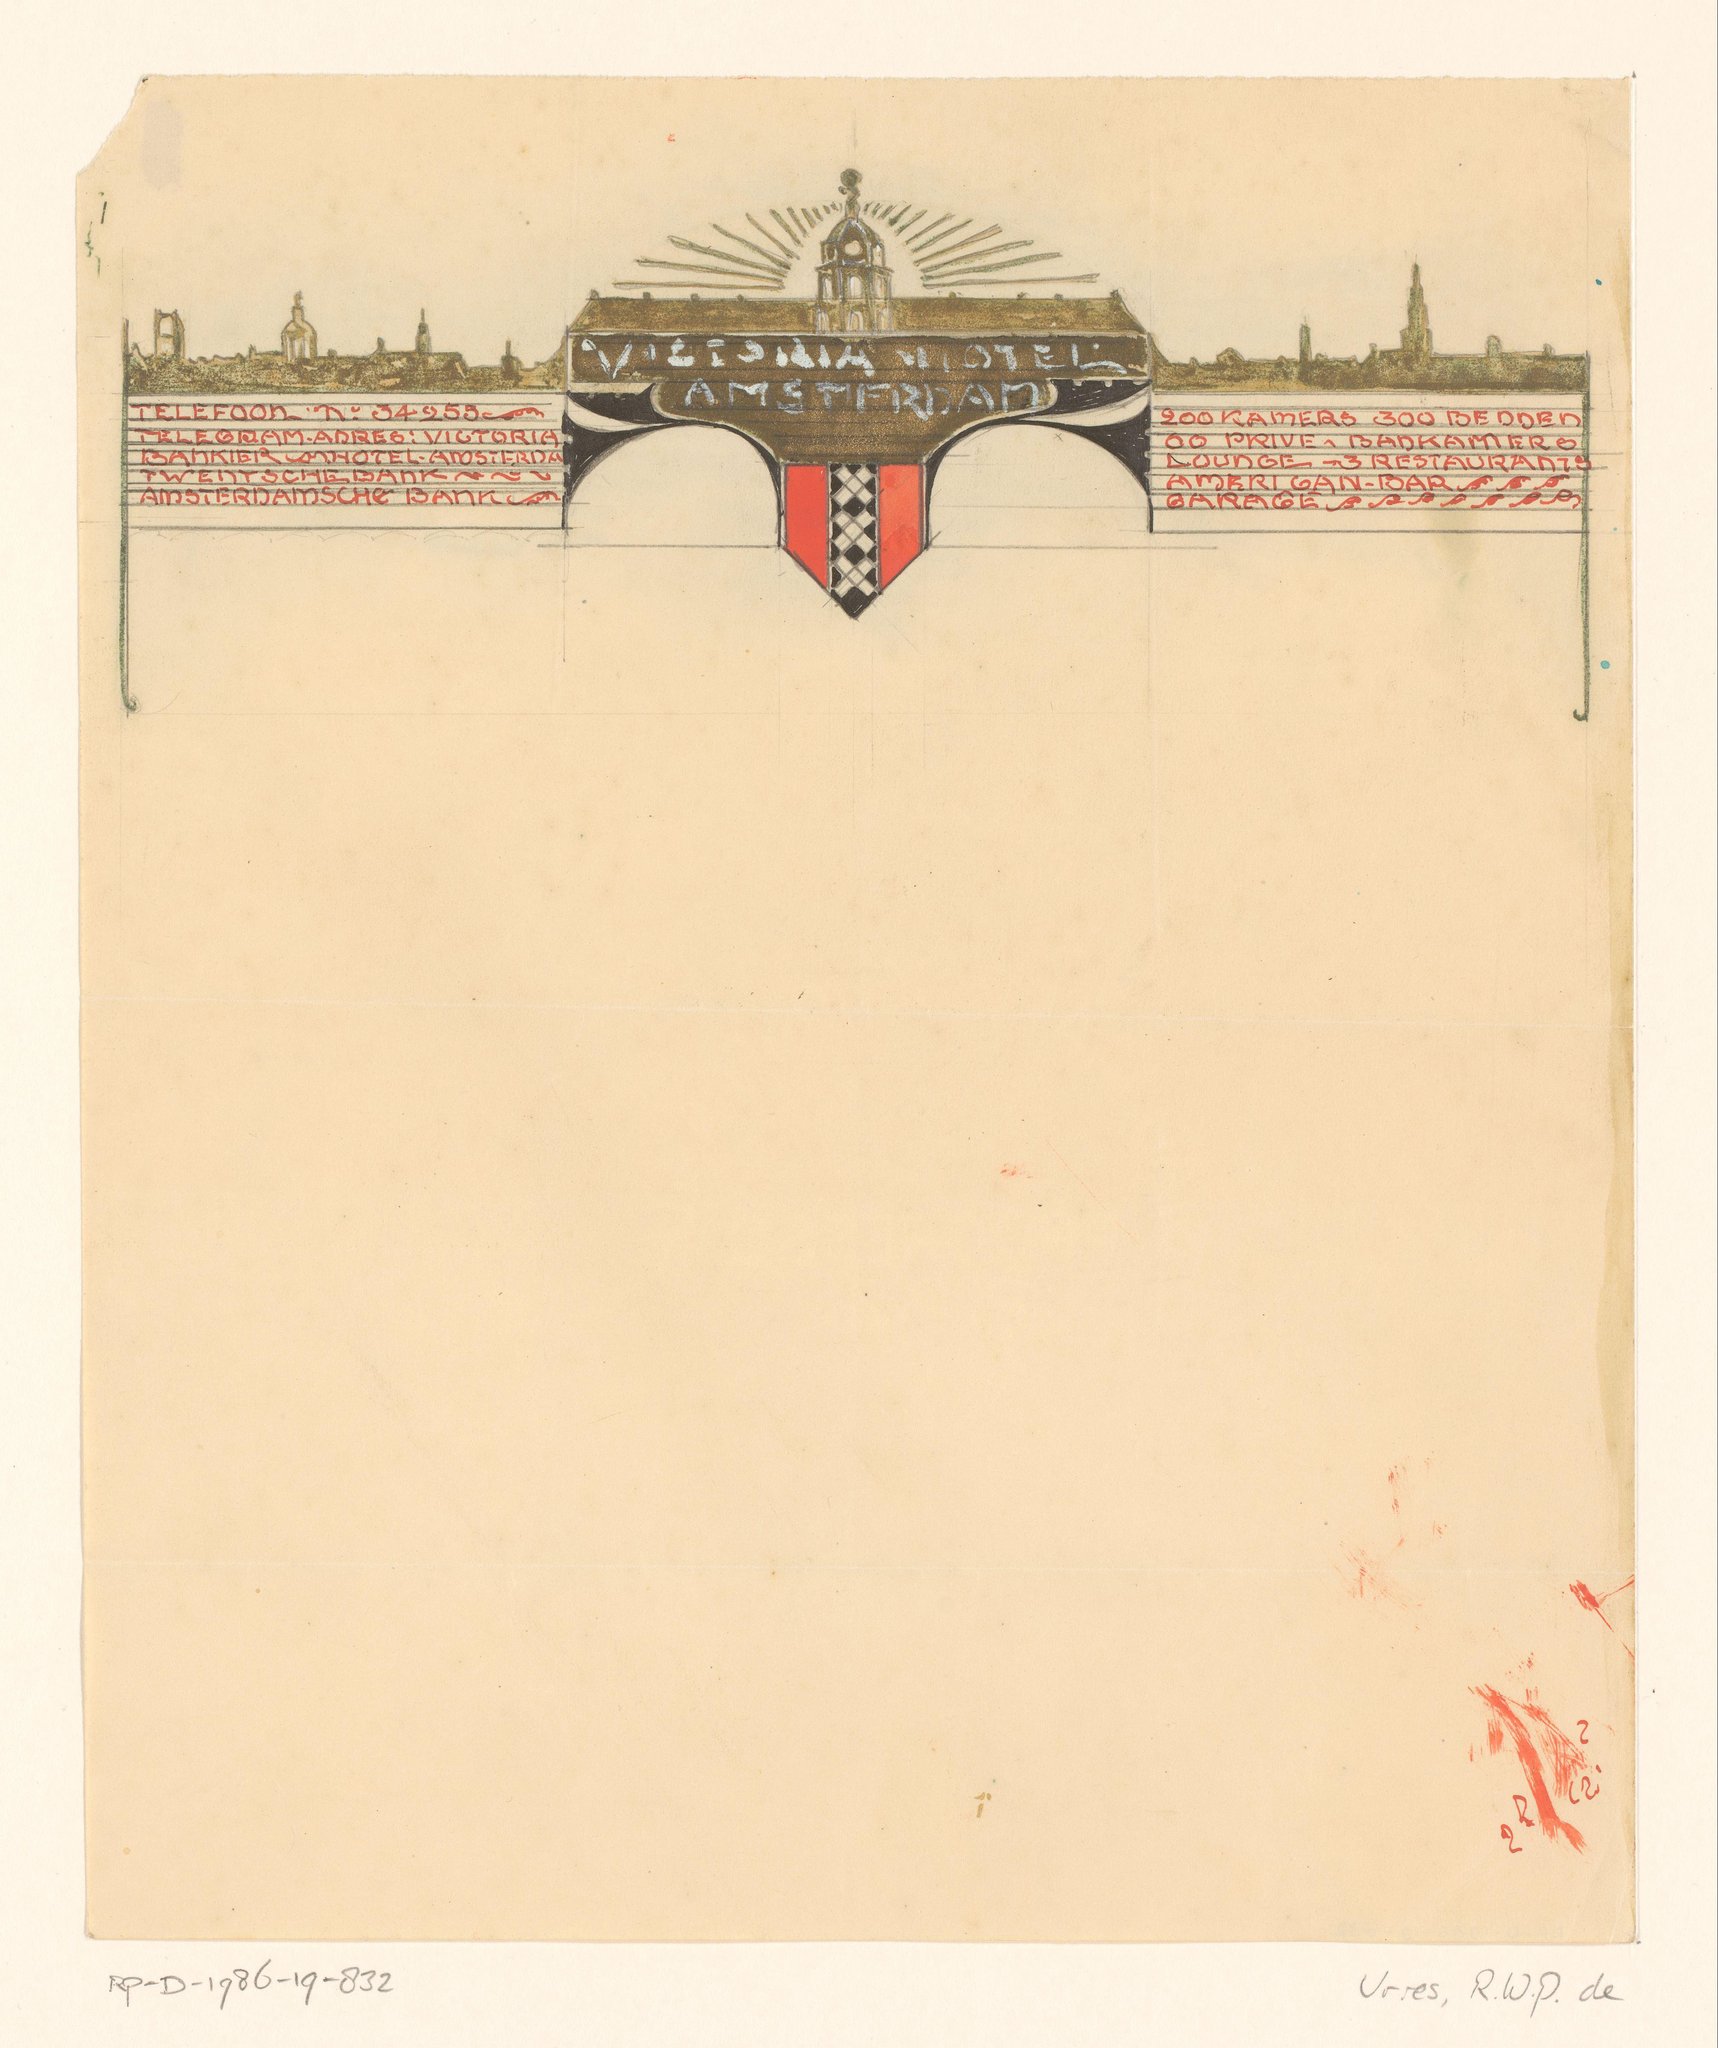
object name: design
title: Ontwerp voor een briefhoofd voor het Victoria Hotel in Amsterdam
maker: reinier willem petrus de vries (1874-1953)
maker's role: draughtsman, print maker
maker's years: 1874-1953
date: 1935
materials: paint, ink, paper, pencil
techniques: brush, pen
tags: city-view, and landscape with man-made constructions, dome ~ architecture, amsterdam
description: Ontwerp met een gezicht op Amsterdam met centraal de koepel van het Victoria Hotel en onderaan het wapen van Amsterdam.